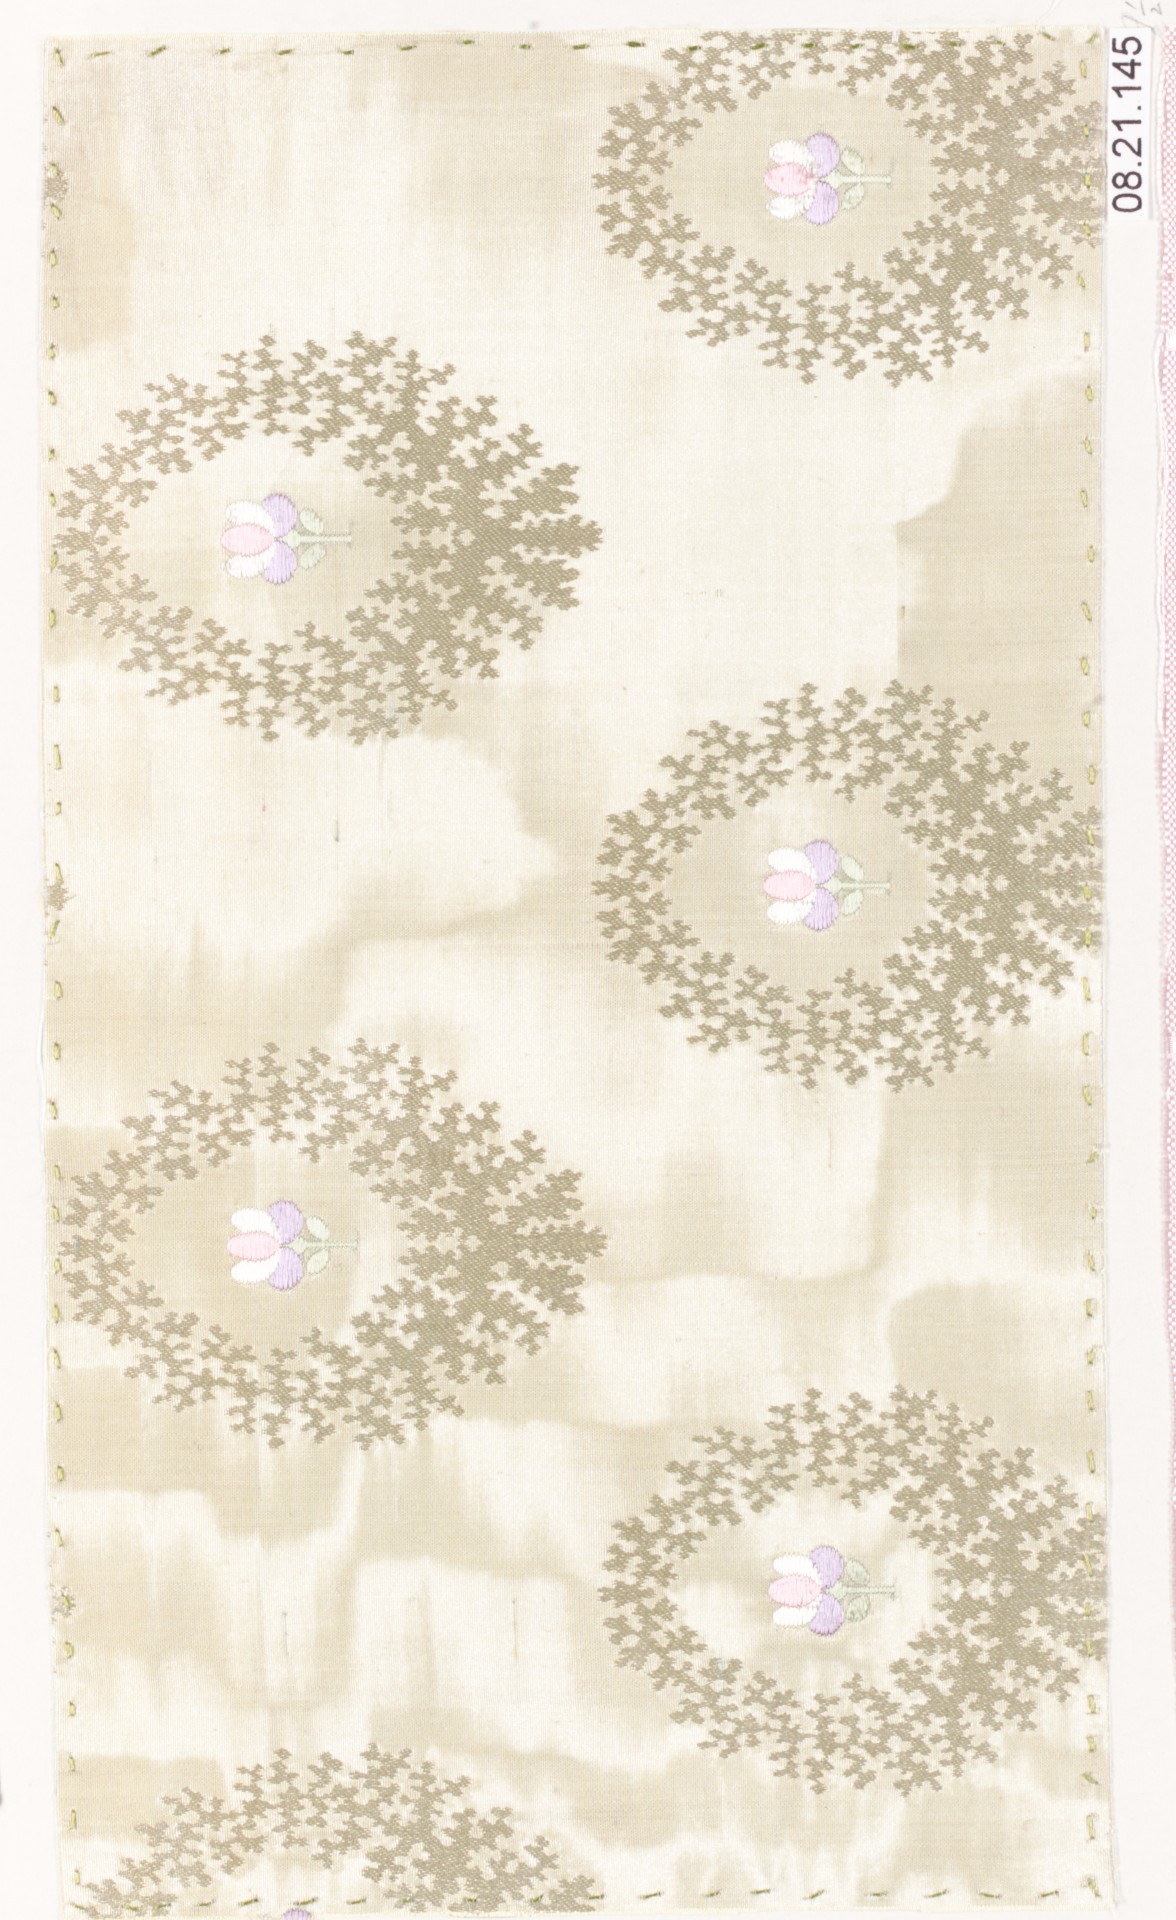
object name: textile sample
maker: Anonymous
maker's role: designer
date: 1900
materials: silk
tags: flowers